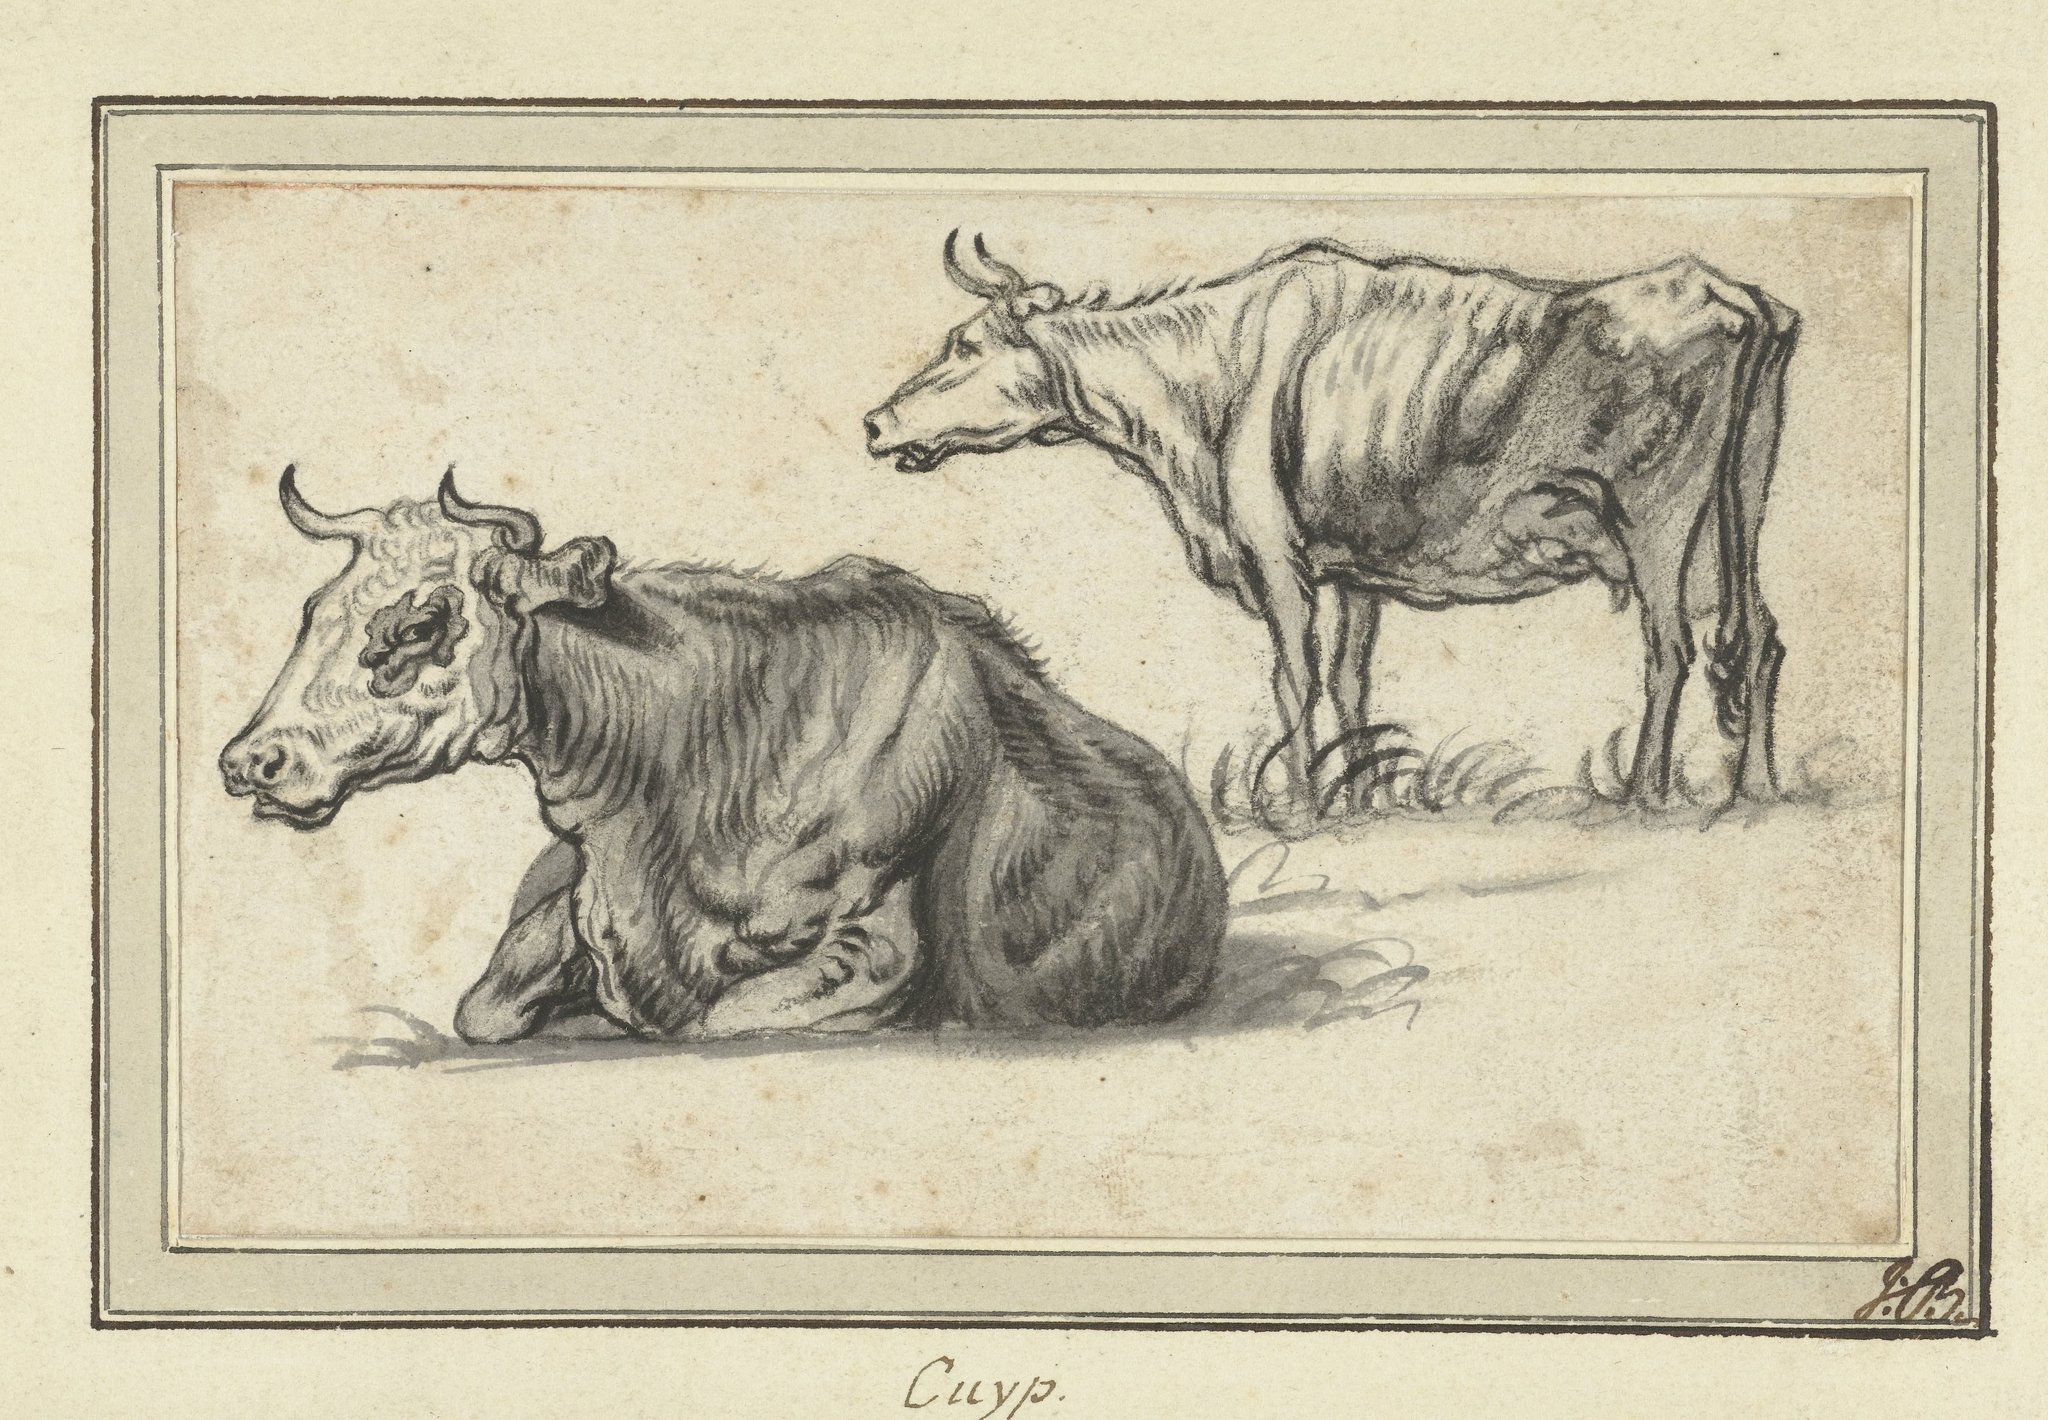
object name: drawing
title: Liggende en een staande koe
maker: aelbert cuyp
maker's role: draughtsman, painter, print maker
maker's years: 1620-1691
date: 1630-1691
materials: chalk, paper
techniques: brush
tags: cow